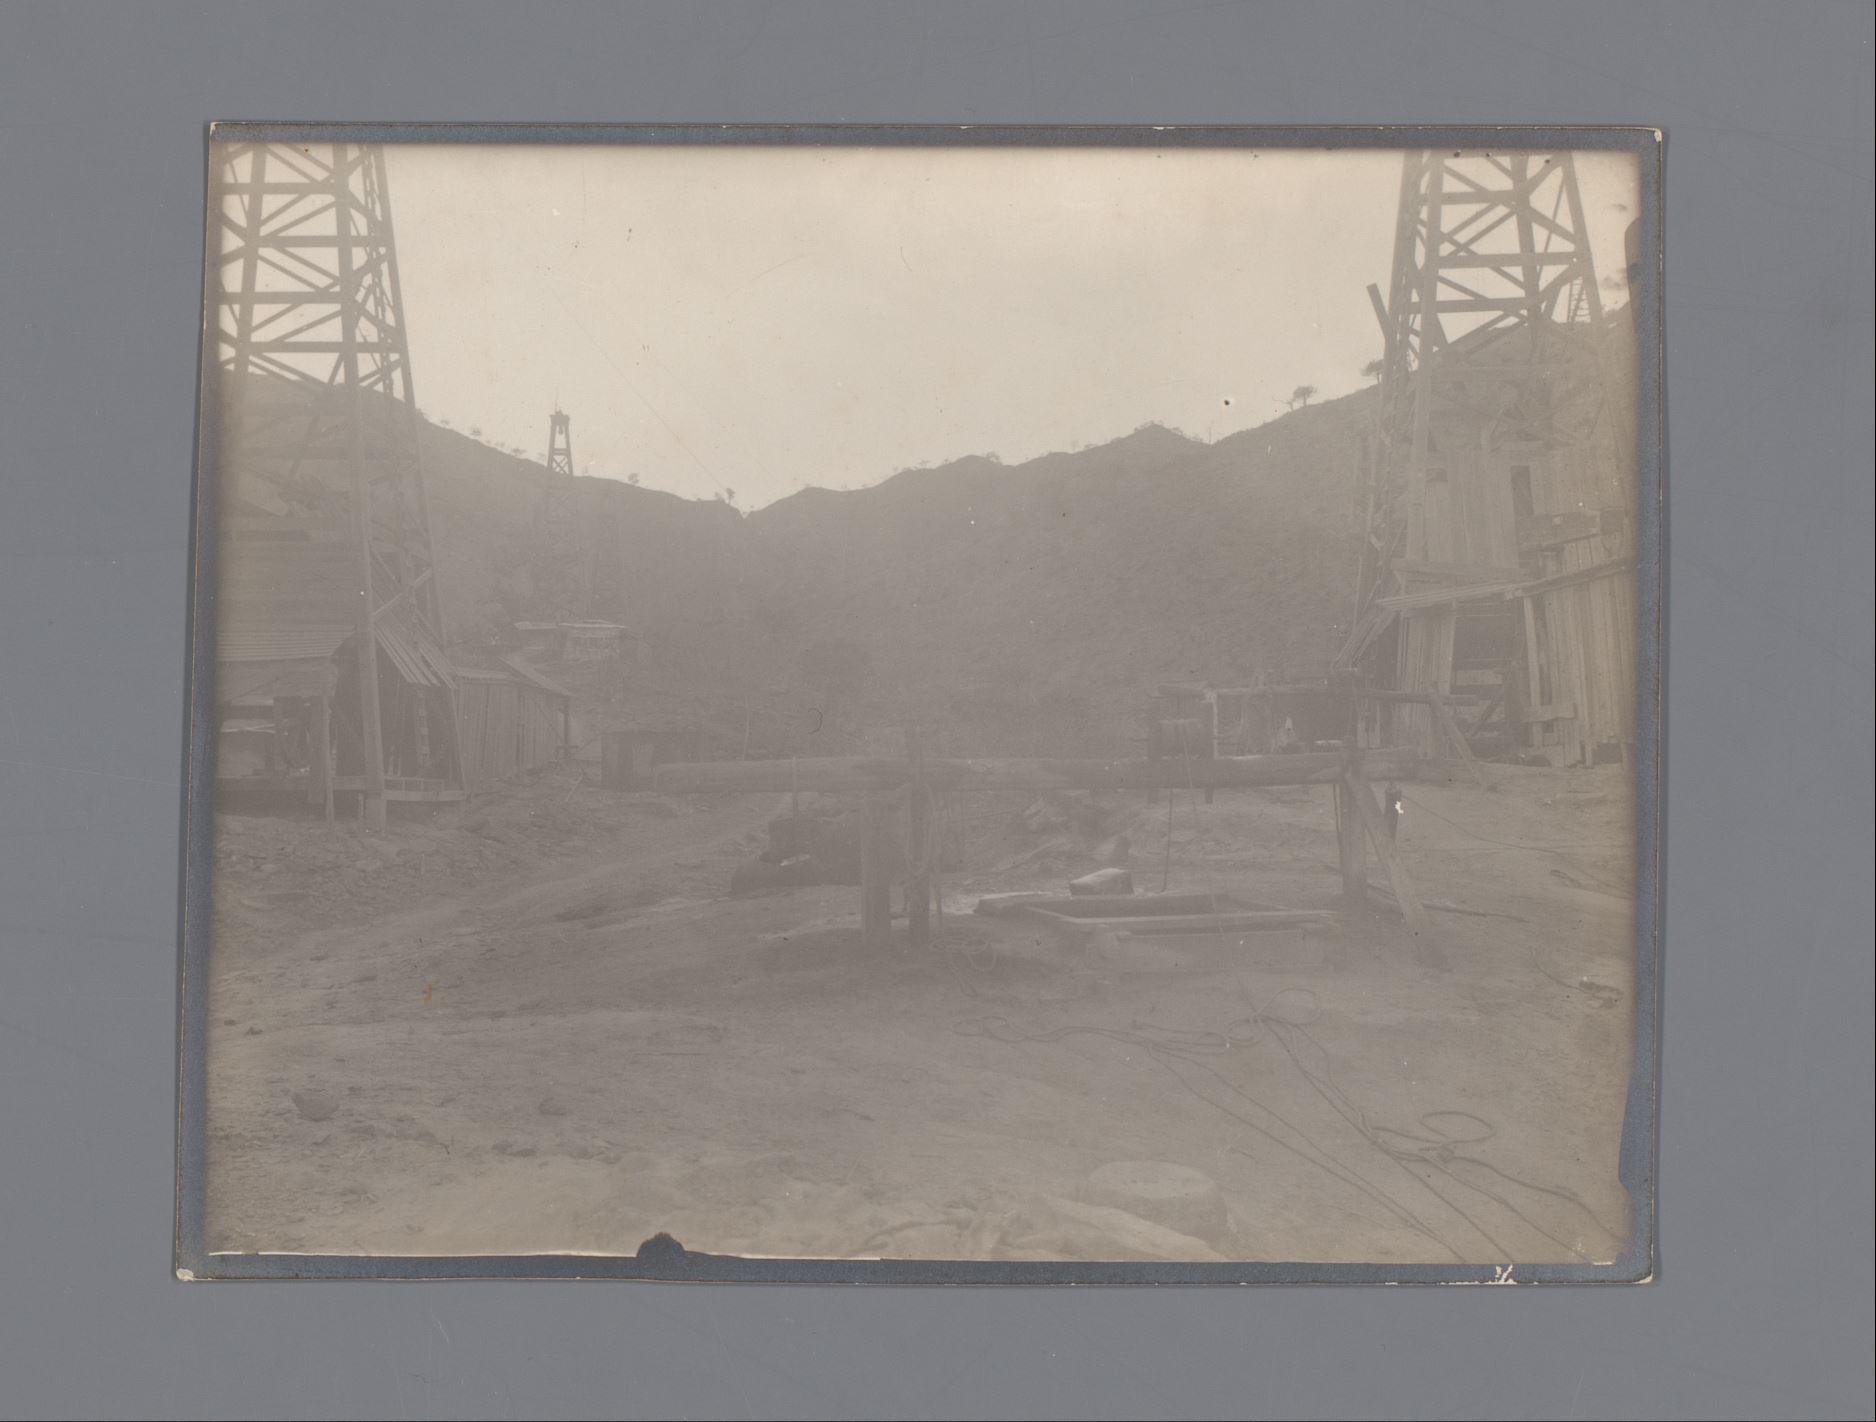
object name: photograph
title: Een mijngebied in de bergen, Zuid-Oost Azië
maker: jan adriani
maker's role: fotograaf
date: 1907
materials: photographic support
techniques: gelatin silver print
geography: southeast asia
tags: surface structures and surroundings of a mine